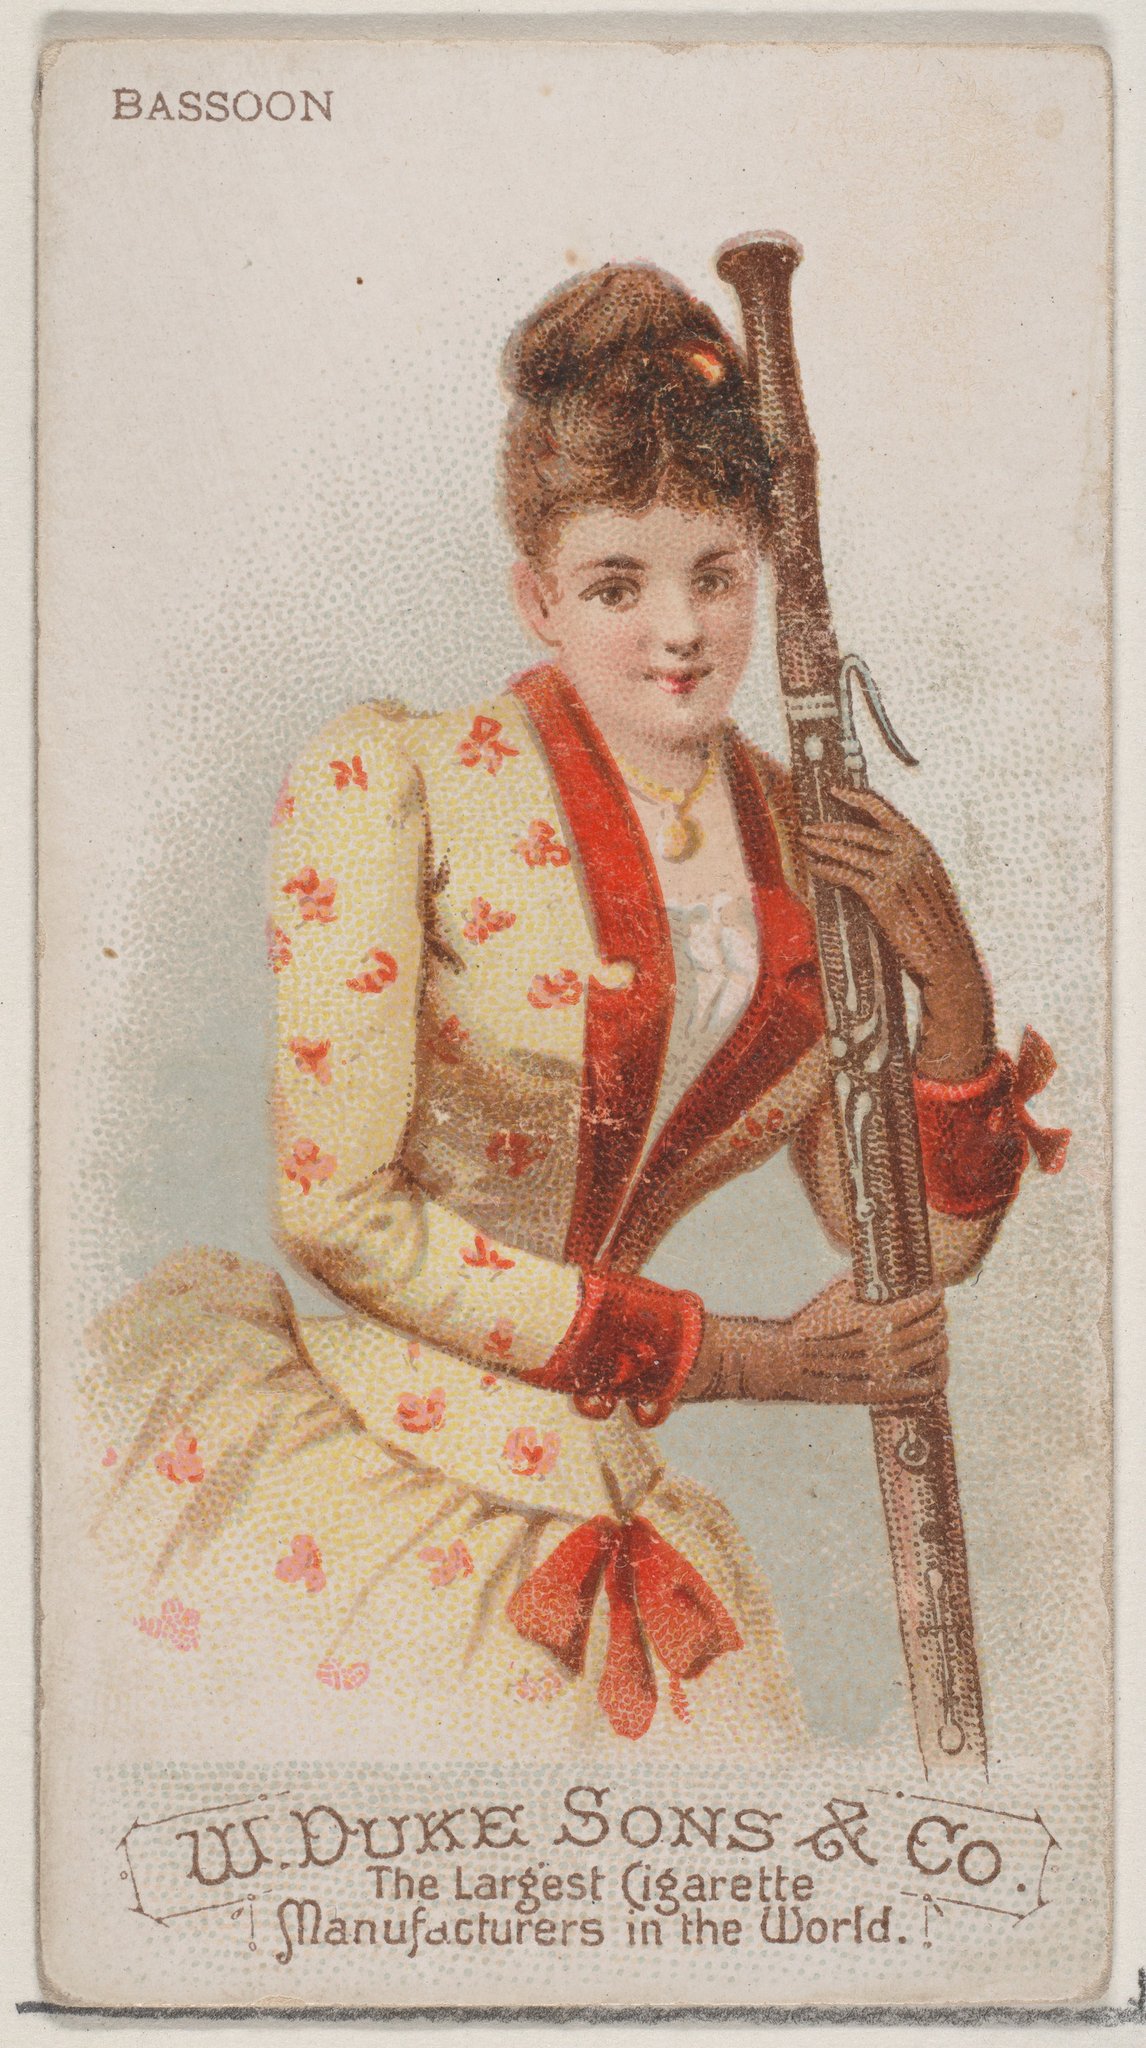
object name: print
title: Bassoon, from the Musical Instruments series (N82) for Duke brand cigarettes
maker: w. duke, sons & co.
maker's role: publisher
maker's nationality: american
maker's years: 1870-1920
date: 1888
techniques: color lithograph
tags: musical instruments,women,musicians